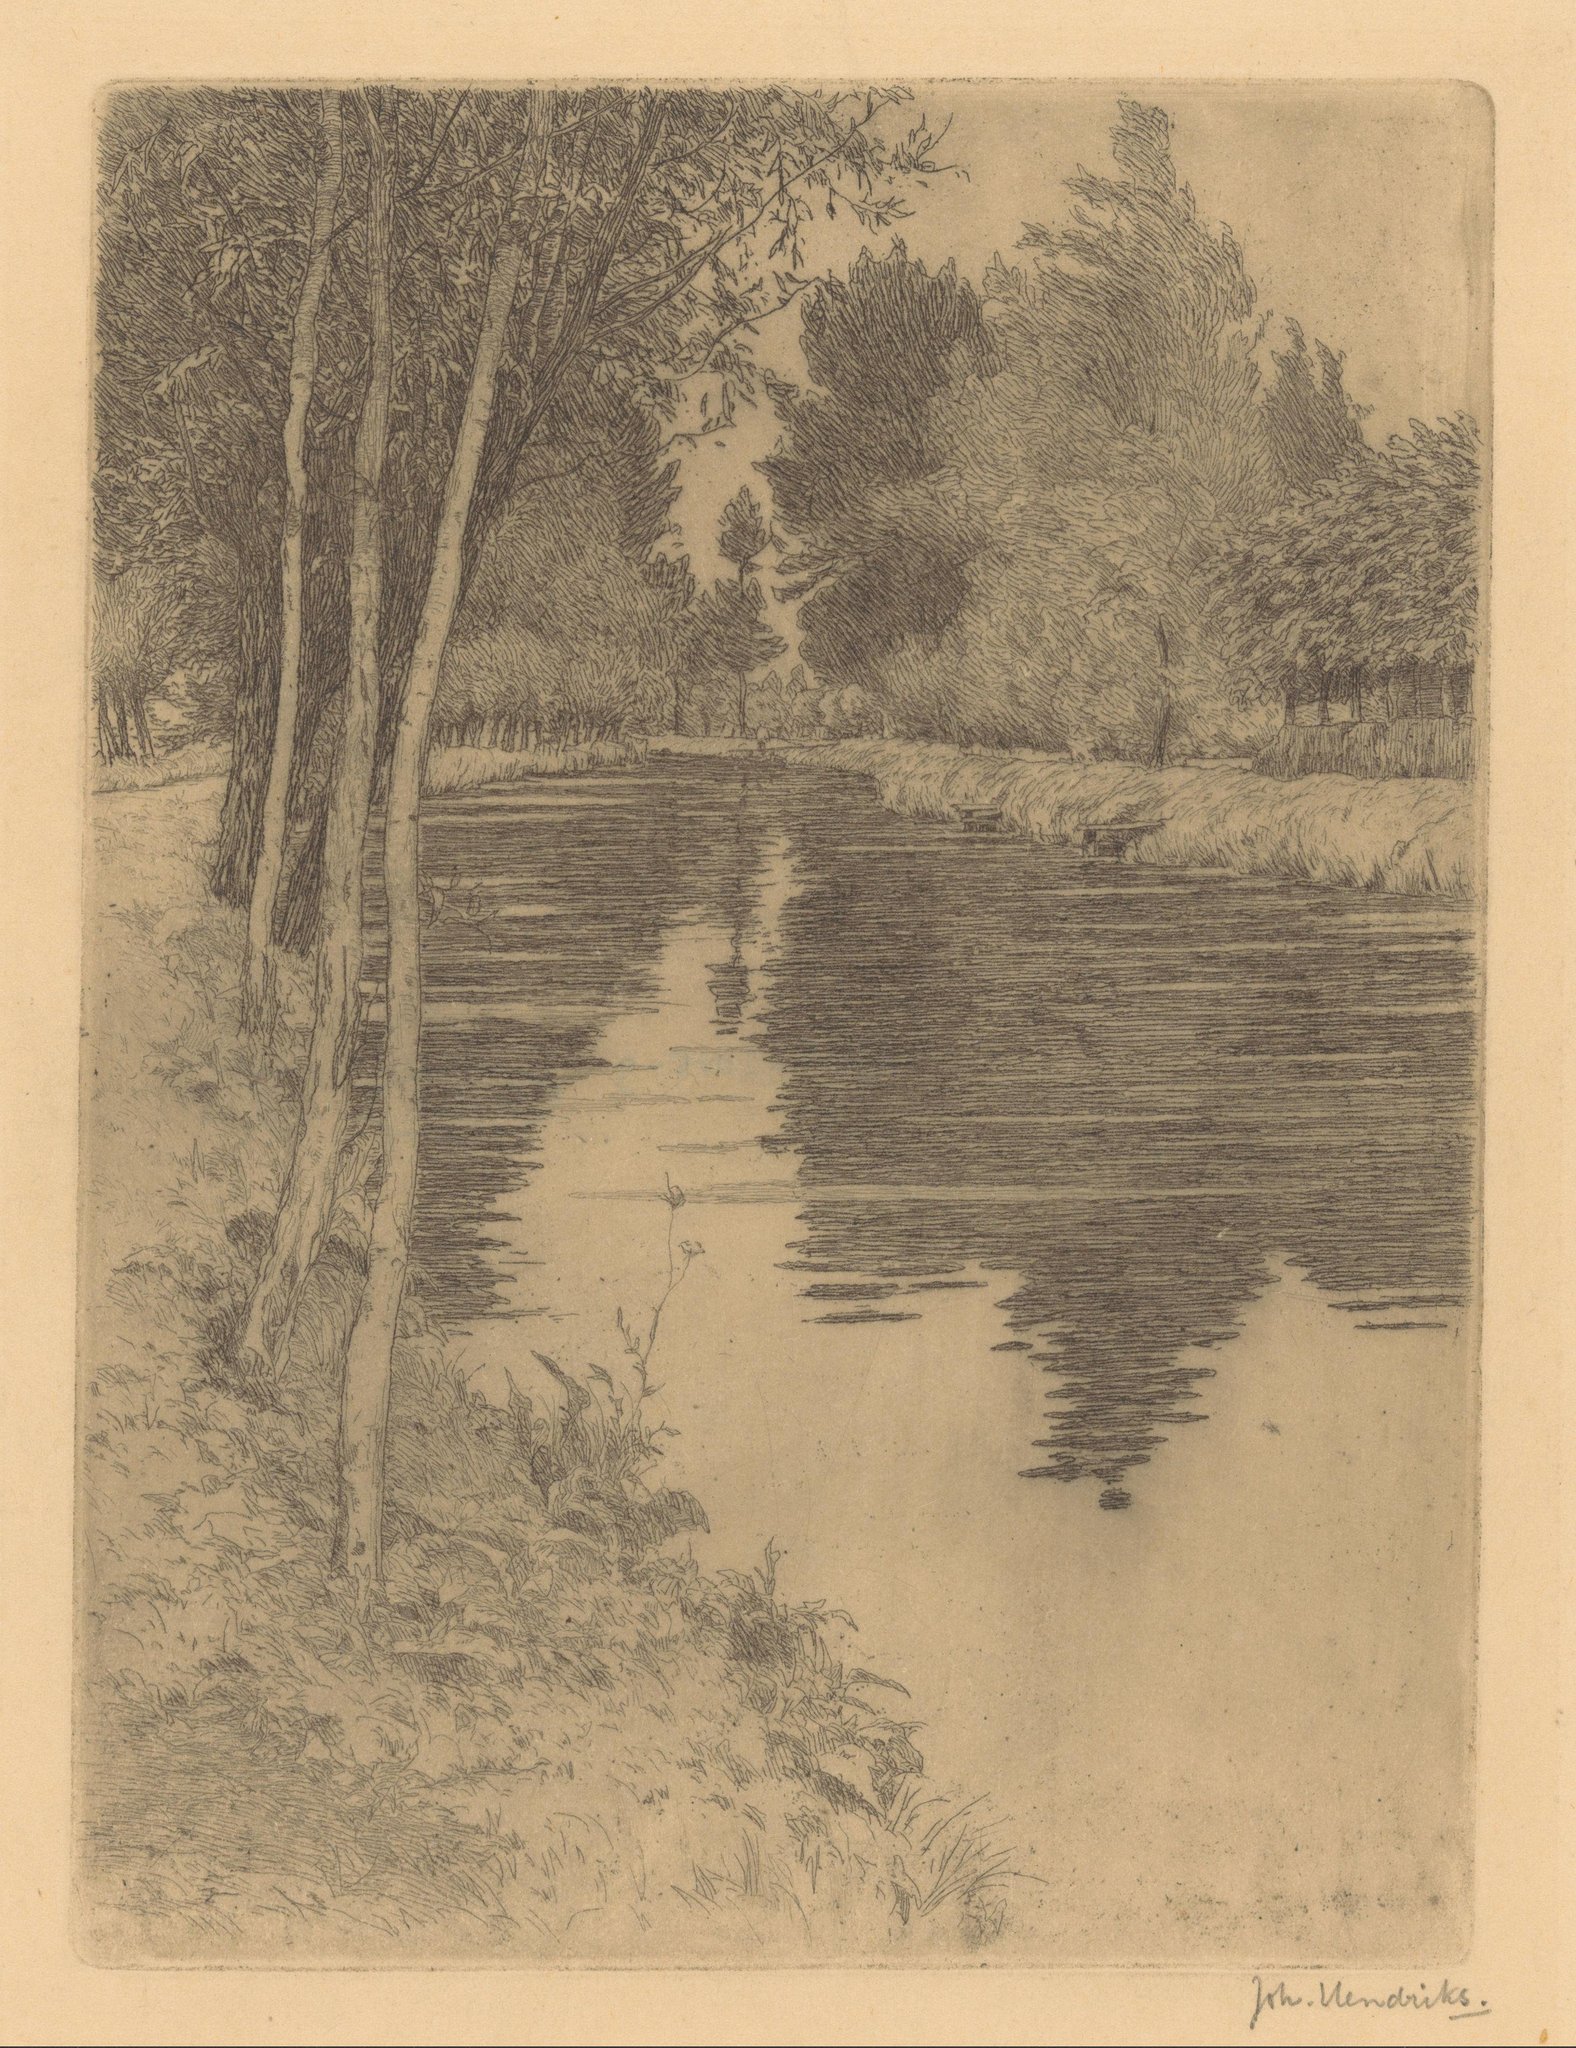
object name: print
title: Lange Linschoten bij Oudewater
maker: johannes henrichs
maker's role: print maker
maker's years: 1882-1954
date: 1892-1954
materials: paper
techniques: etching, intaglio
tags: trees, river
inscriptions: collector's mark: Lugt 2228, collector's mark: Lugt 2760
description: De met bomen begroeide oevers van de rivier de Lange Linschoten bij Oudewater in de provincie Utrecht.